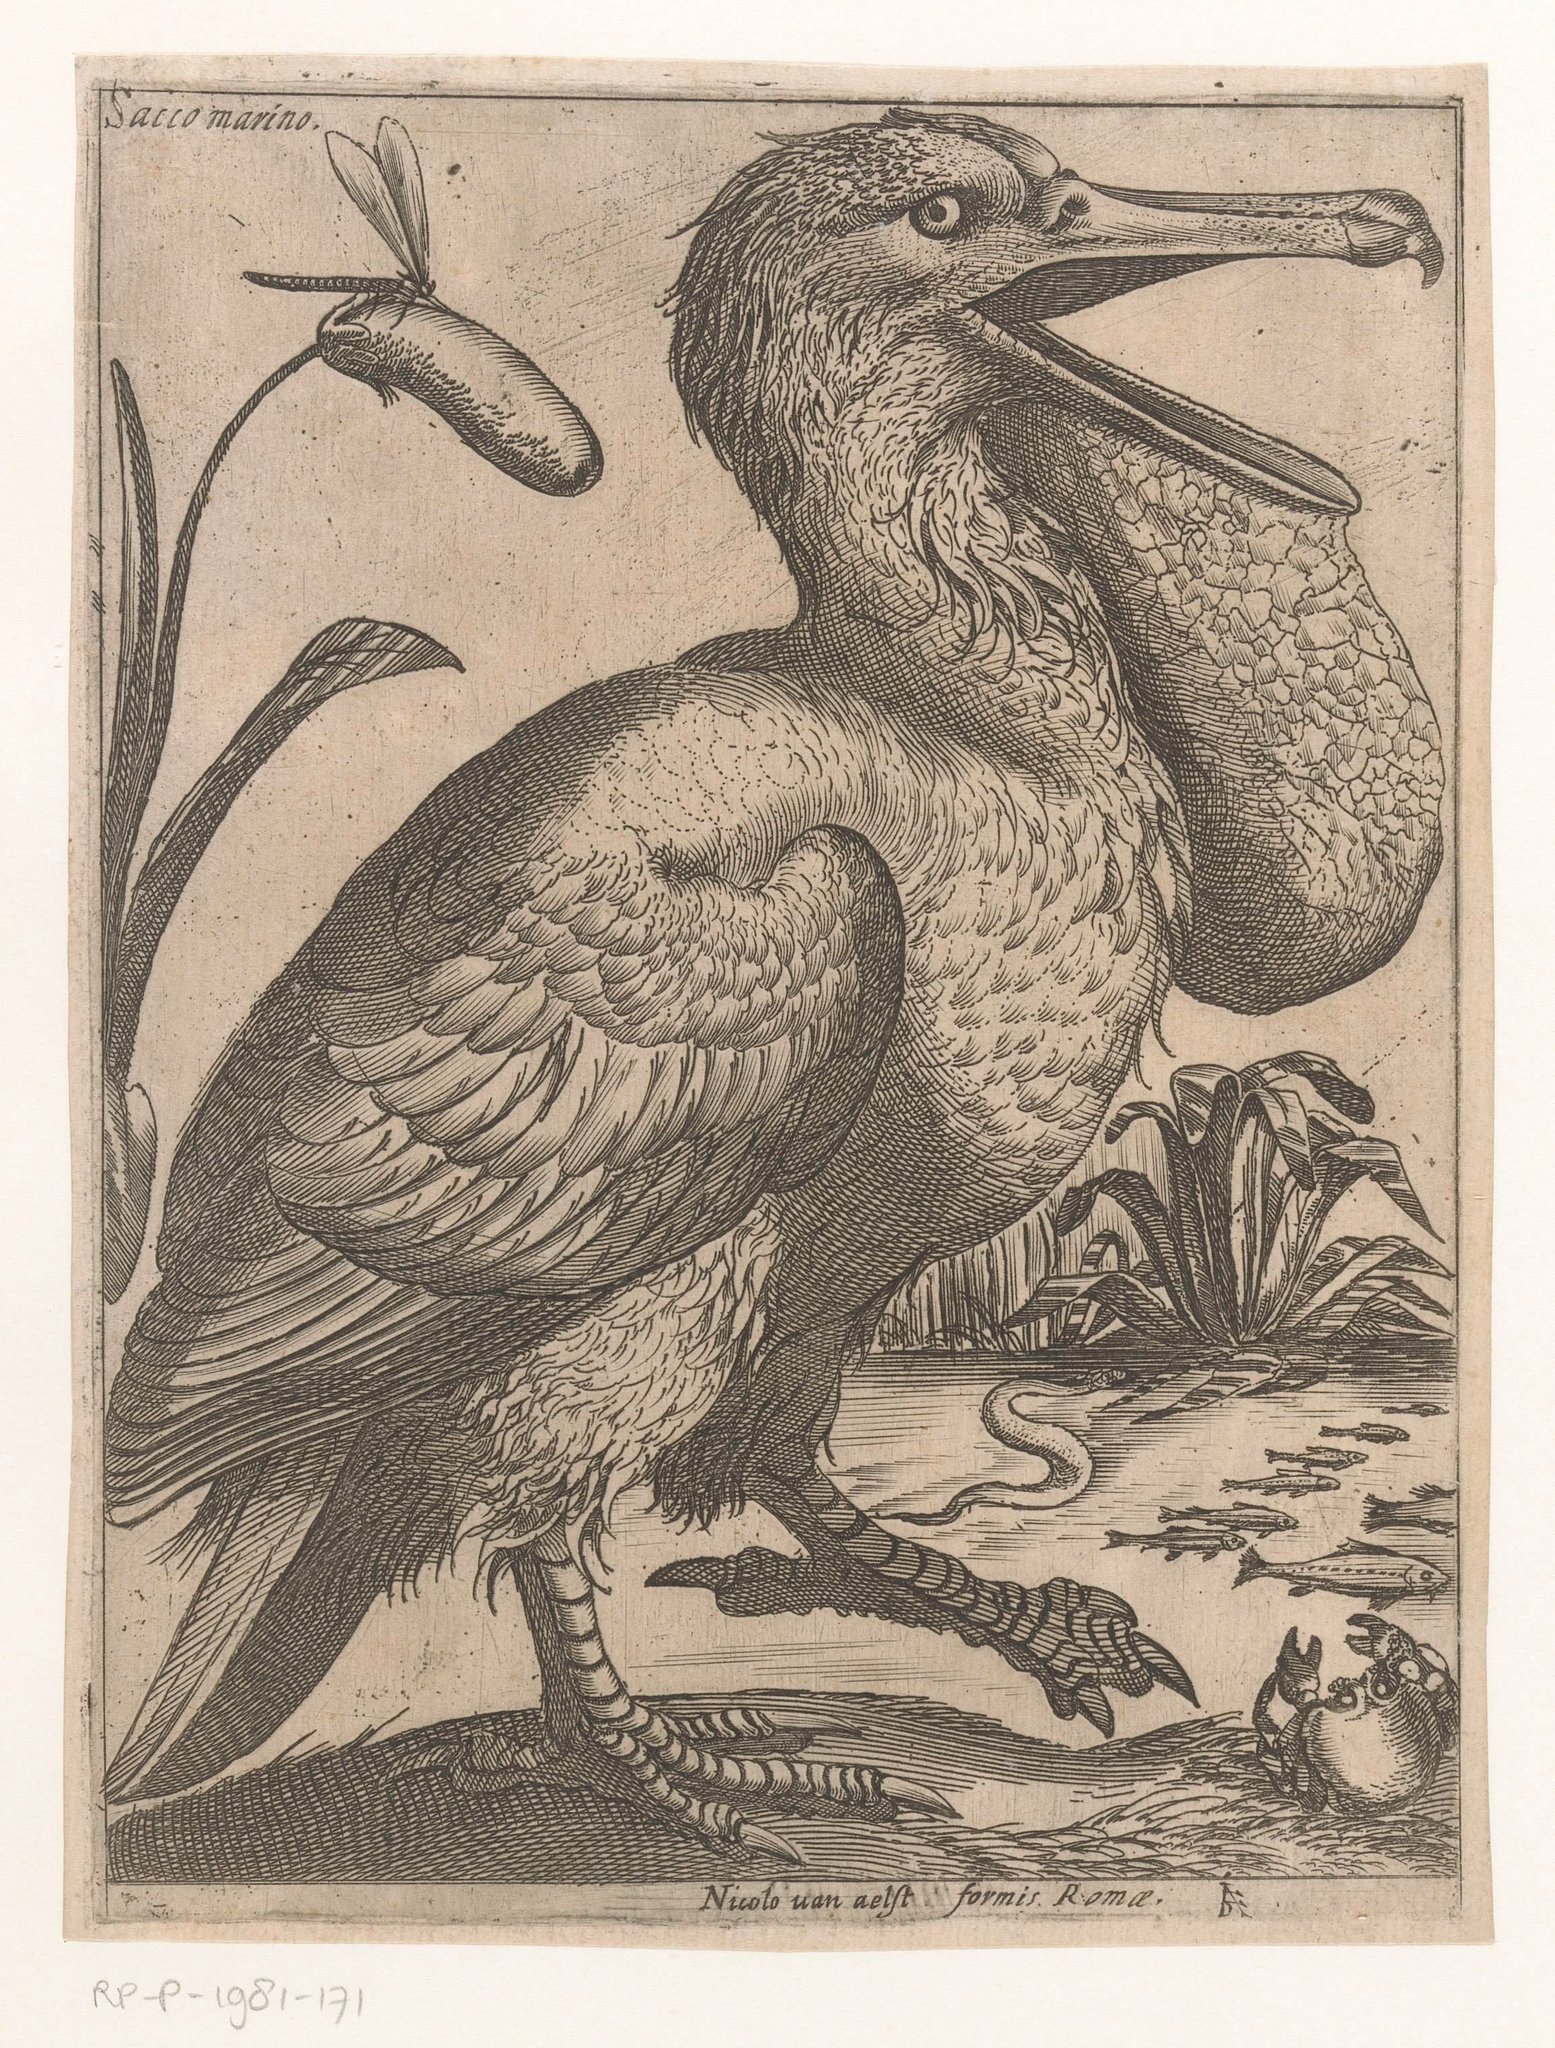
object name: print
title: Sacco Marino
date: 1594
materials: paper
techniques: etching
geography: italy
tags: birds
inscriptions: collector's mark: Lugt 2228, collector's mark: Lugt 2760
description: Een watervogel, vermoedelijk een pelikaan, aan de waterkant. In het water een krab, vissen en een waterslang.